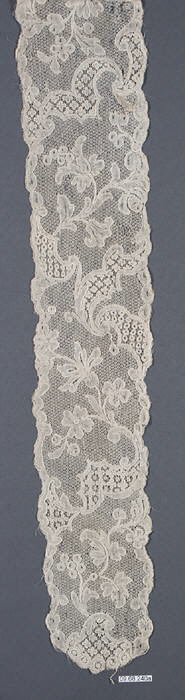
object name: lappet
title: Lappet (one of a pair)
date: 1701-1733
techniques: lace